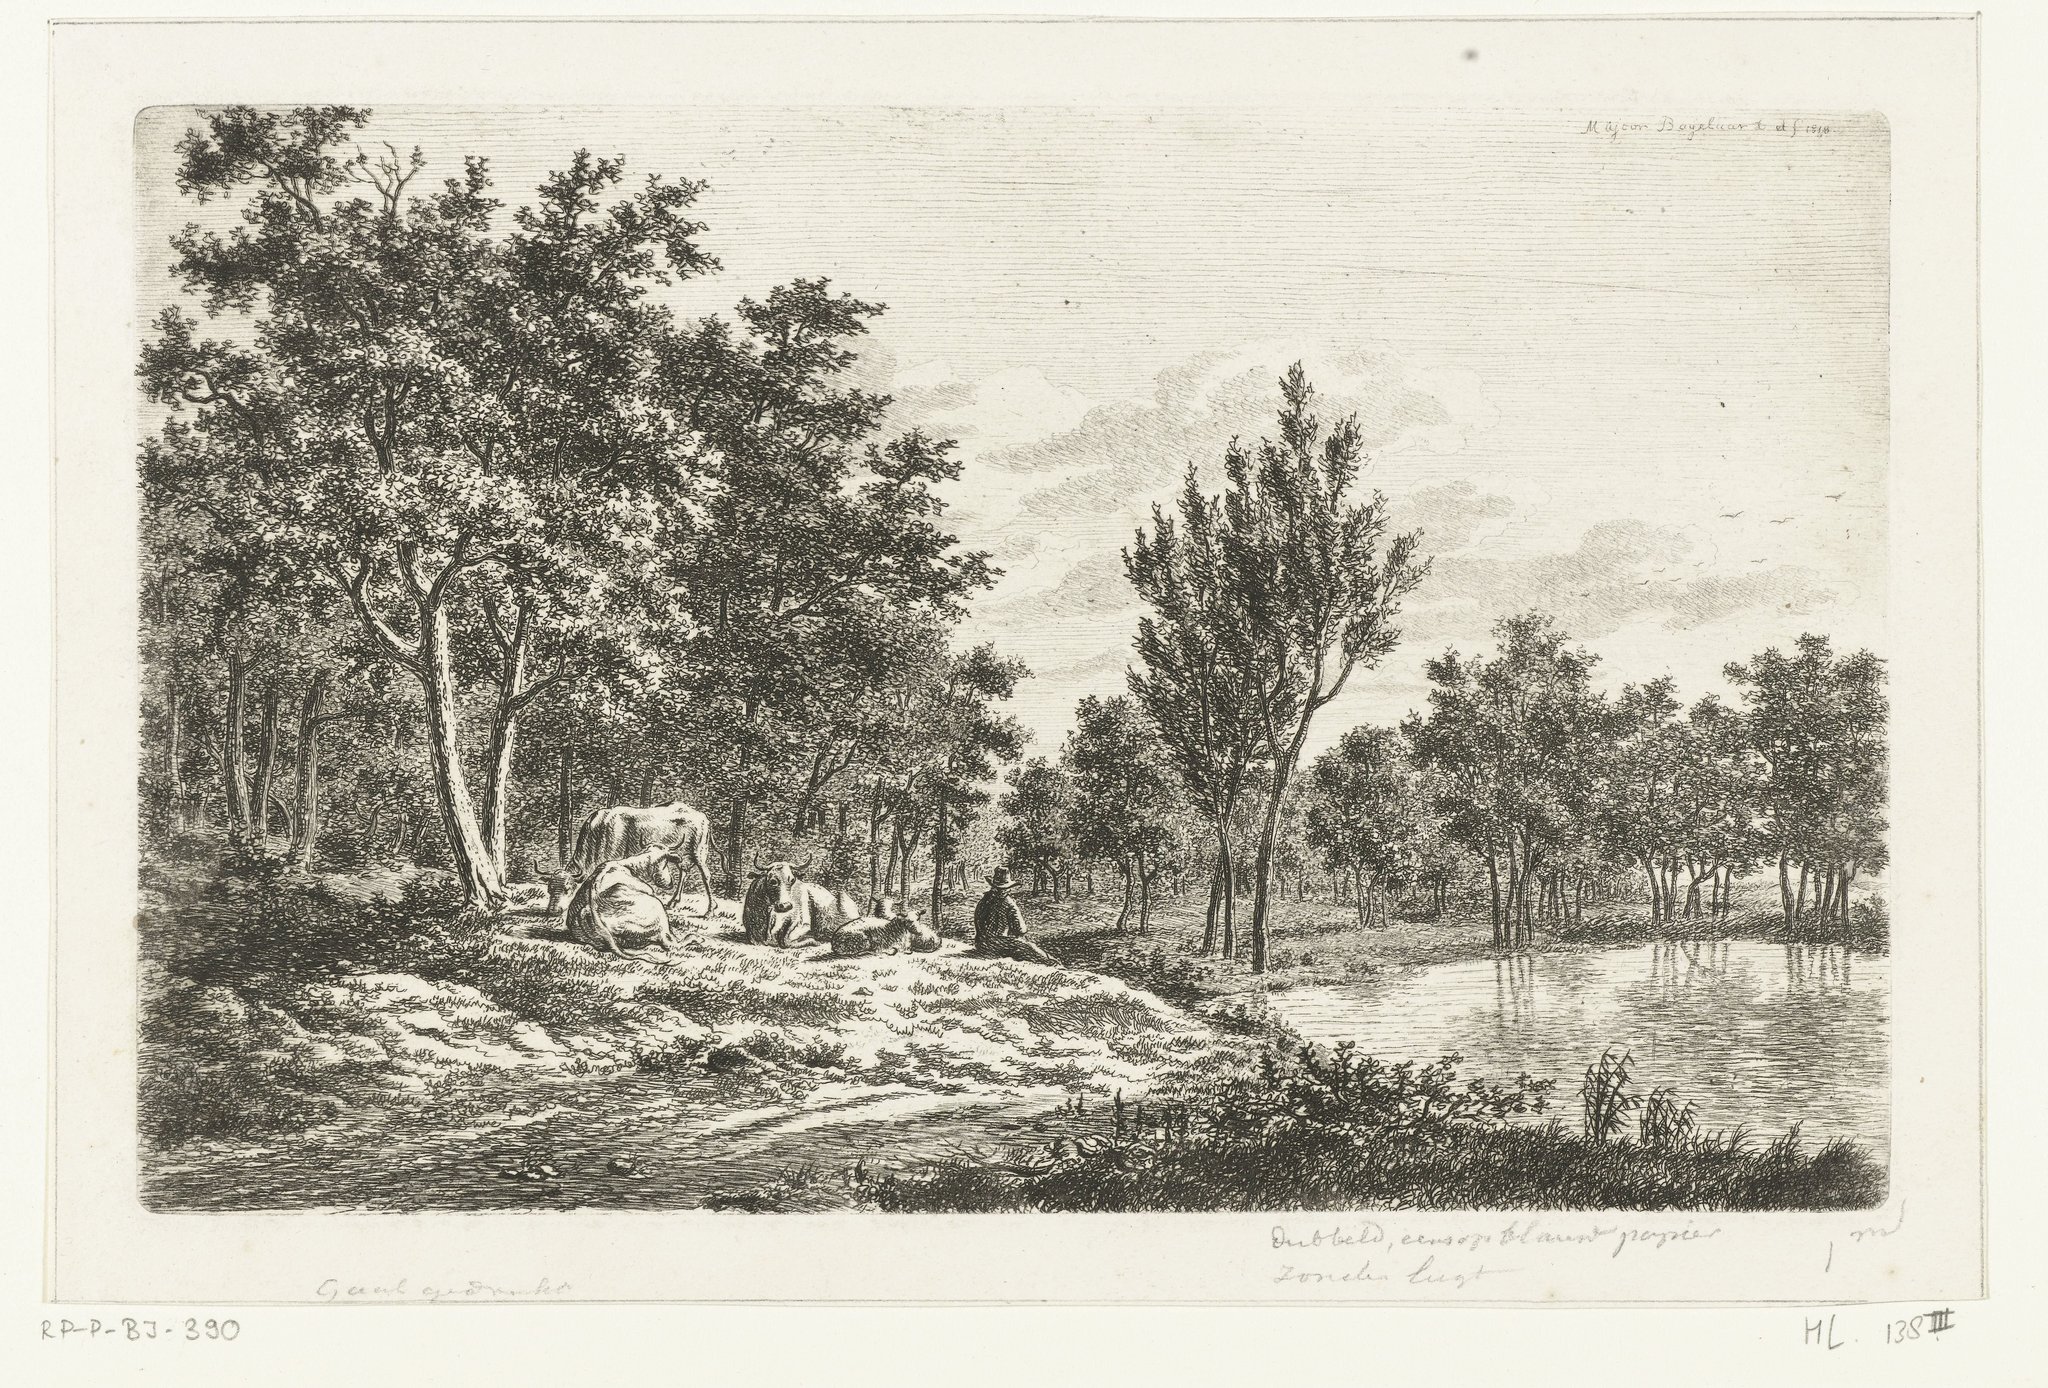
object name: print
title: Landschap met herder en zijn kudde bij een vijver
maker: ernst willem jan bagelaar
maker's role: draughtsman, print maker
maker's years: 1775-1837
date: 1818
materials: paper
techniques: drypoint, etching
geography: netherlands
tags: herding, herdsman, herdswoman, shepherd, shepherdess, cowherd, etc., pond, pool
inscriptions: collector's mark: Lugt 2228